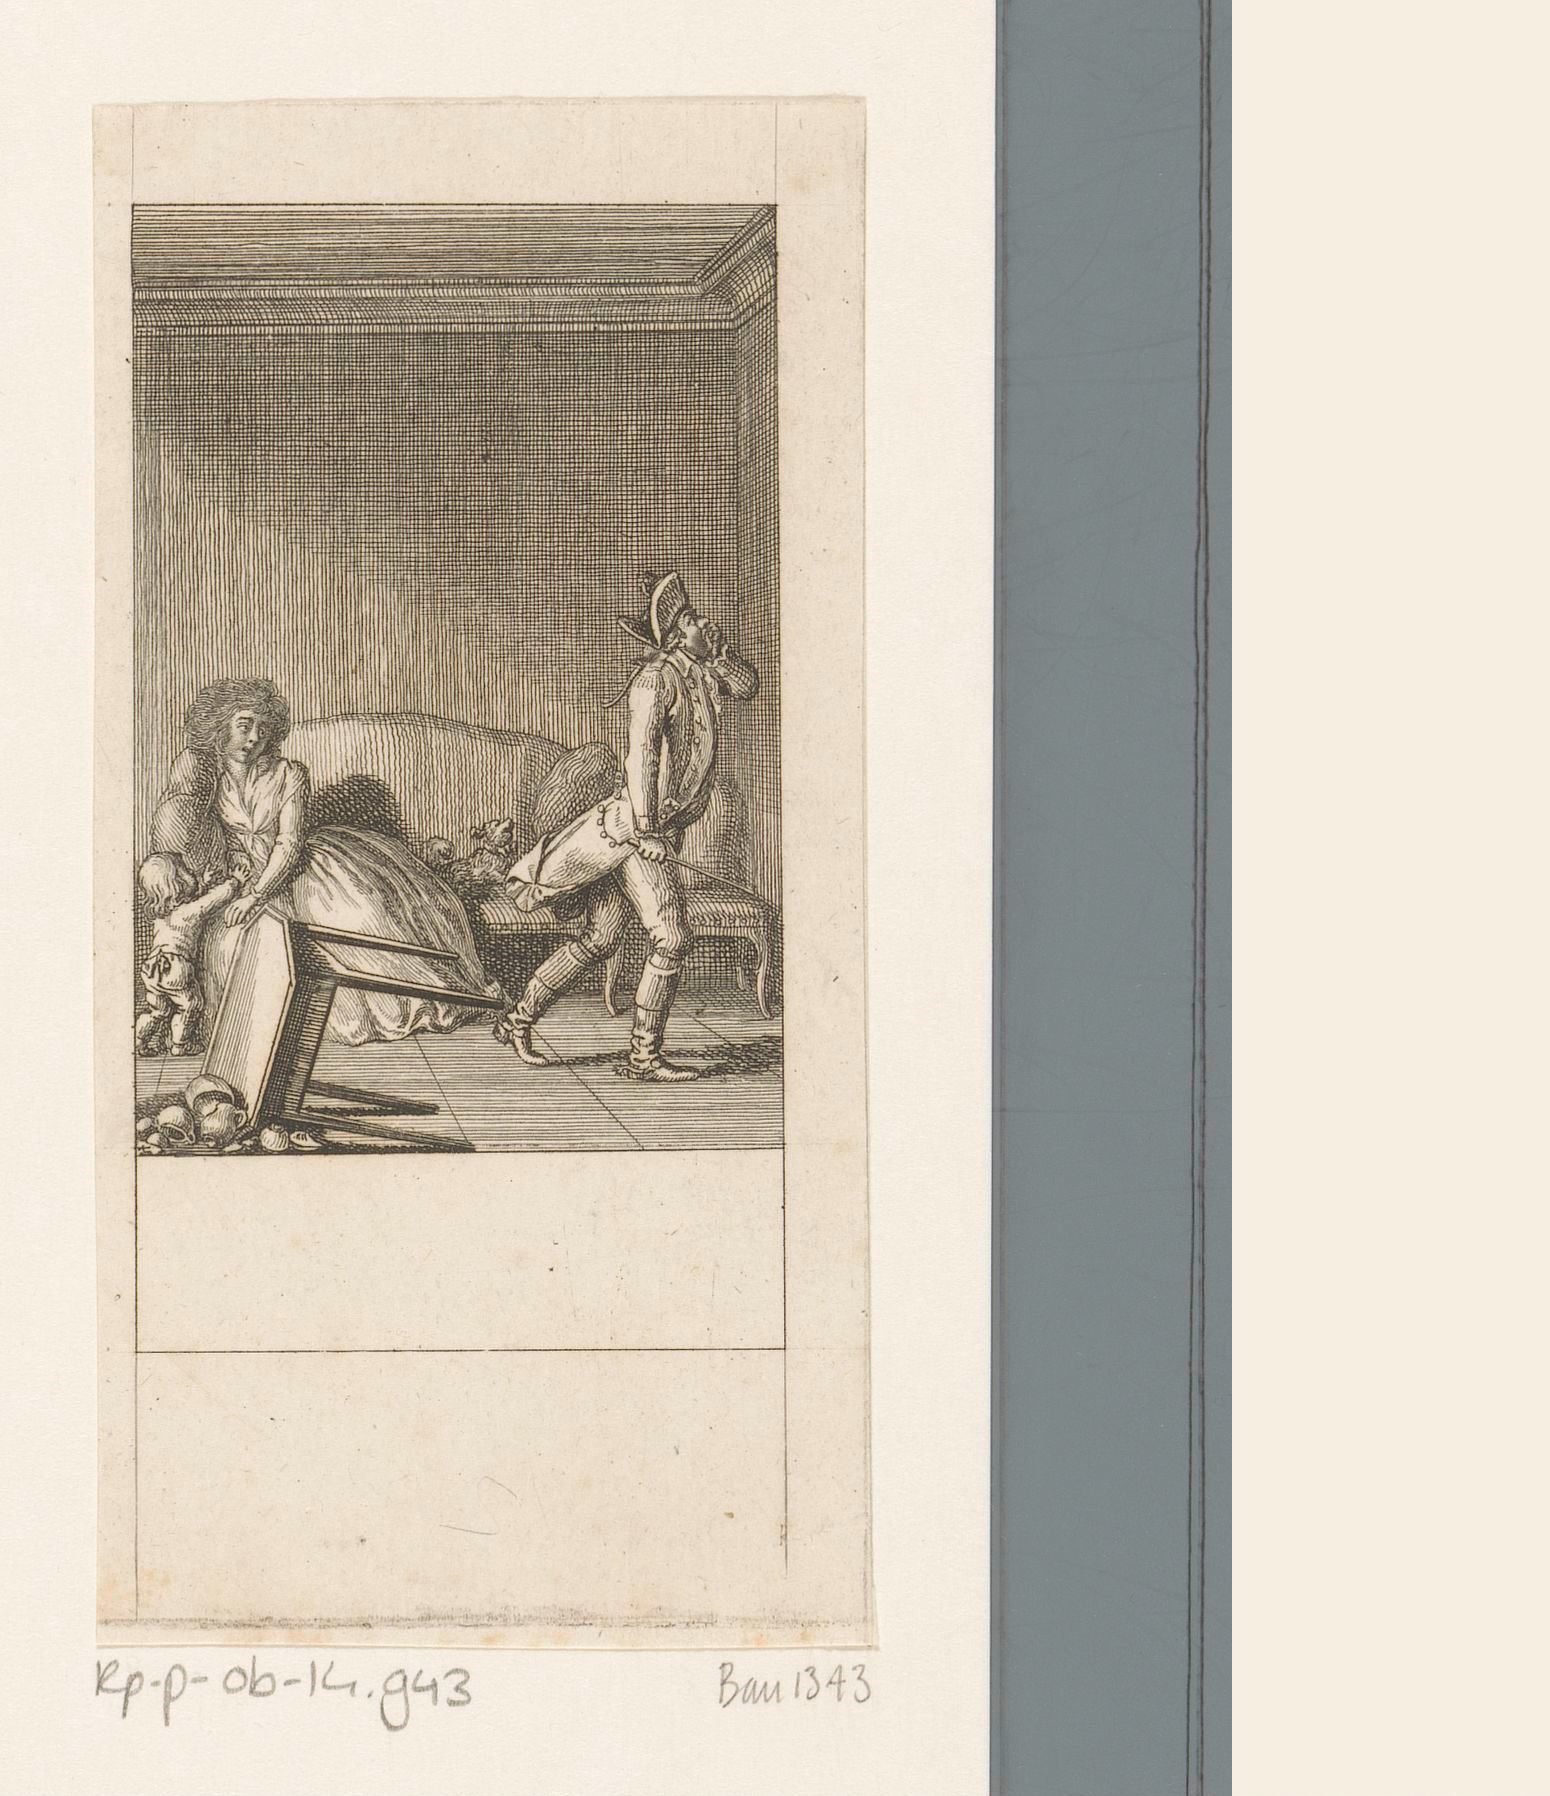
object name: print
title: Wanhoop in het huwelijk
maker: daniel nikolaus chodowiecki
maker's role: draughtsman, print maker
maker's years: 1726-1801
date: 1788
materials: paper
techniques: etching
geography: berlin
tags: despair; 'disperatione' (ripa), betrothal and marriage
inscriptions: collector's mark: Lugt 2228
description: Latere staat gebruikt voor: Goettinger Taschen Calender vom Jahr 1789. [Göttingen]: Johann Christoph Dietrich, [1788].